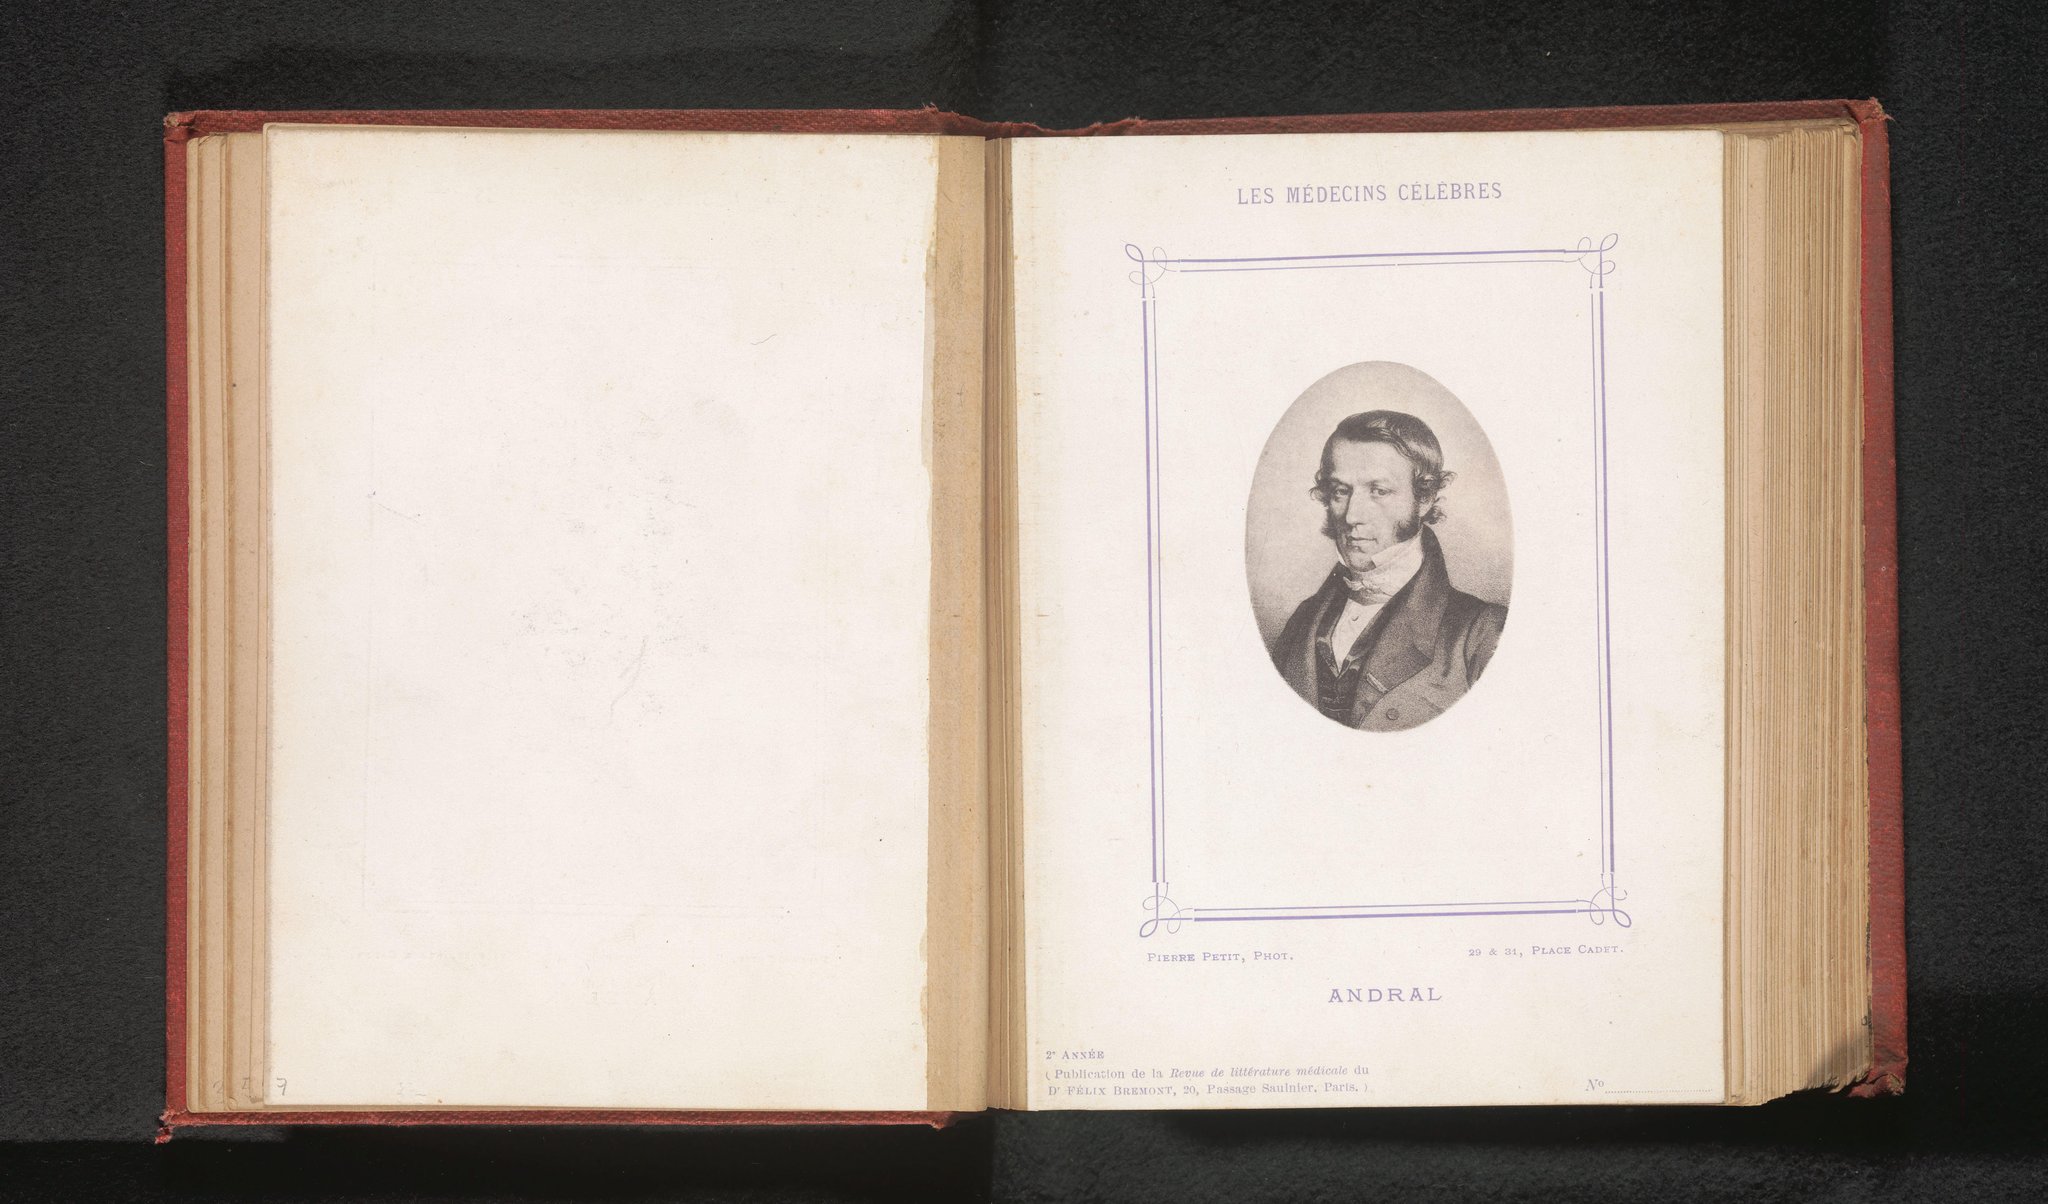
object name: page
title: Andral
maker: pierre petit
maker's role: fotograaf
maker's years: 1832-1909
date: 1871-1879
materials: paper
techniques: photograph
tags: paris, adult man, historical persons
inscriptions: inscription: ‘(Publication de la Revue de litterature médicale du/ D. Félix, Bremond, 20 Passage Saulnier, Paris. No.]’